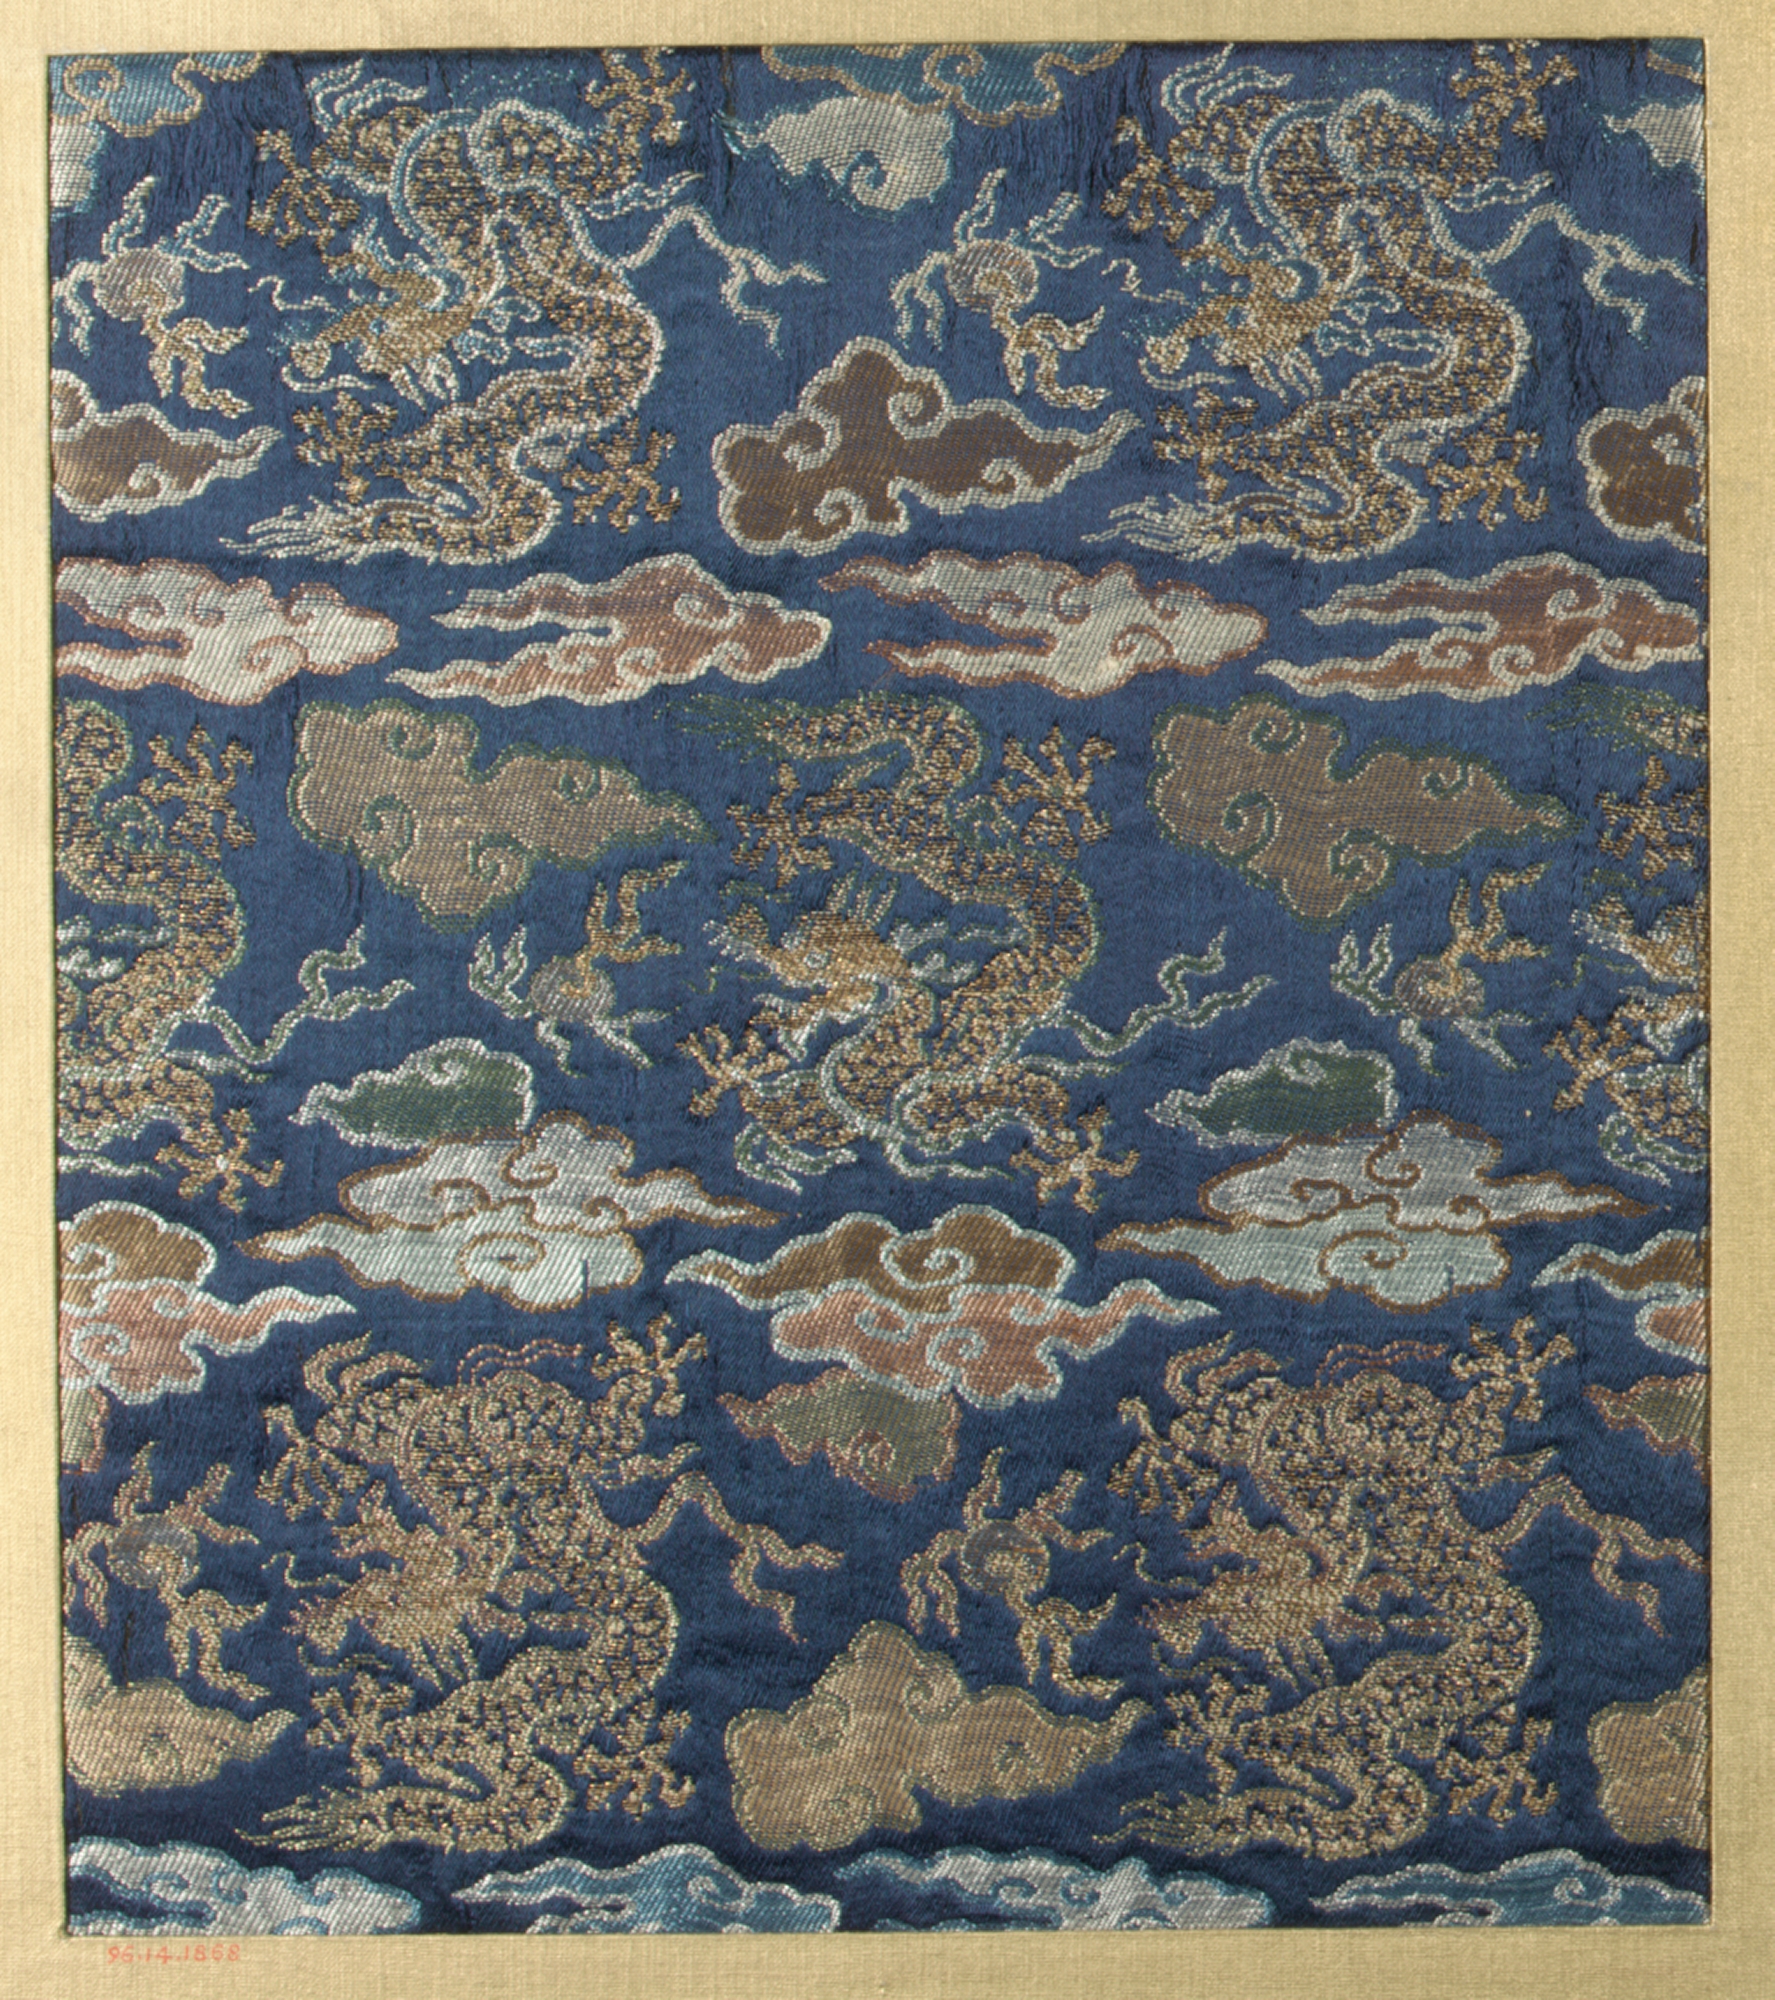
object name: piece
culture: chinese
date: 1701-1900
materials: silk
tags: dragons